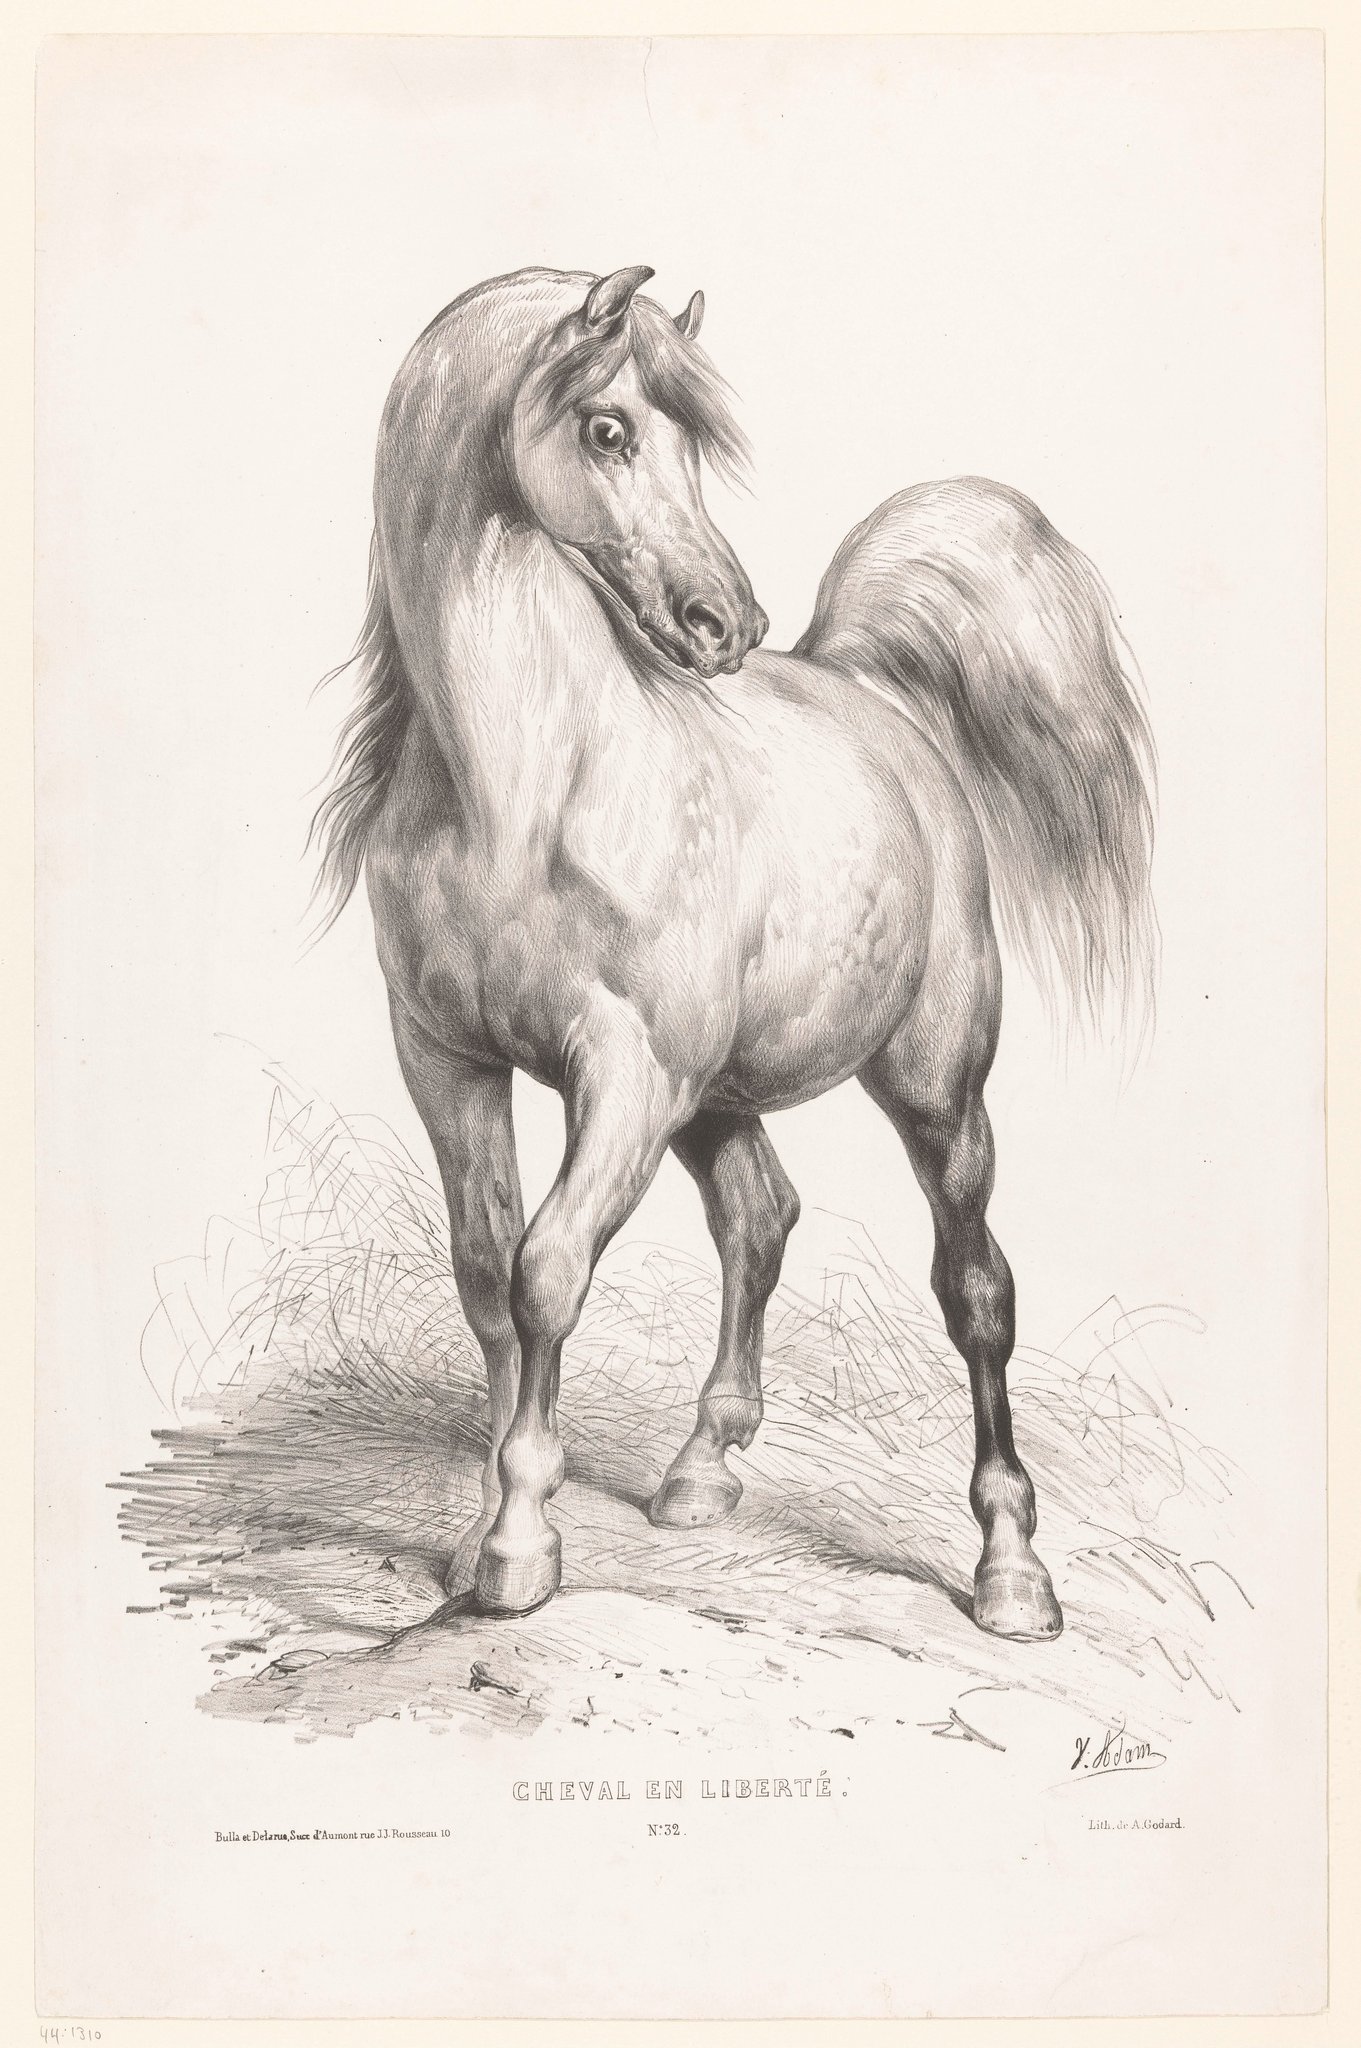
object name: print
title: Cours d'animaux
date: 1843-1844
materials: paper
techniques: lithograph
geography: paris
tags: horse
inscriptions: collector's mark: Lugt 2228